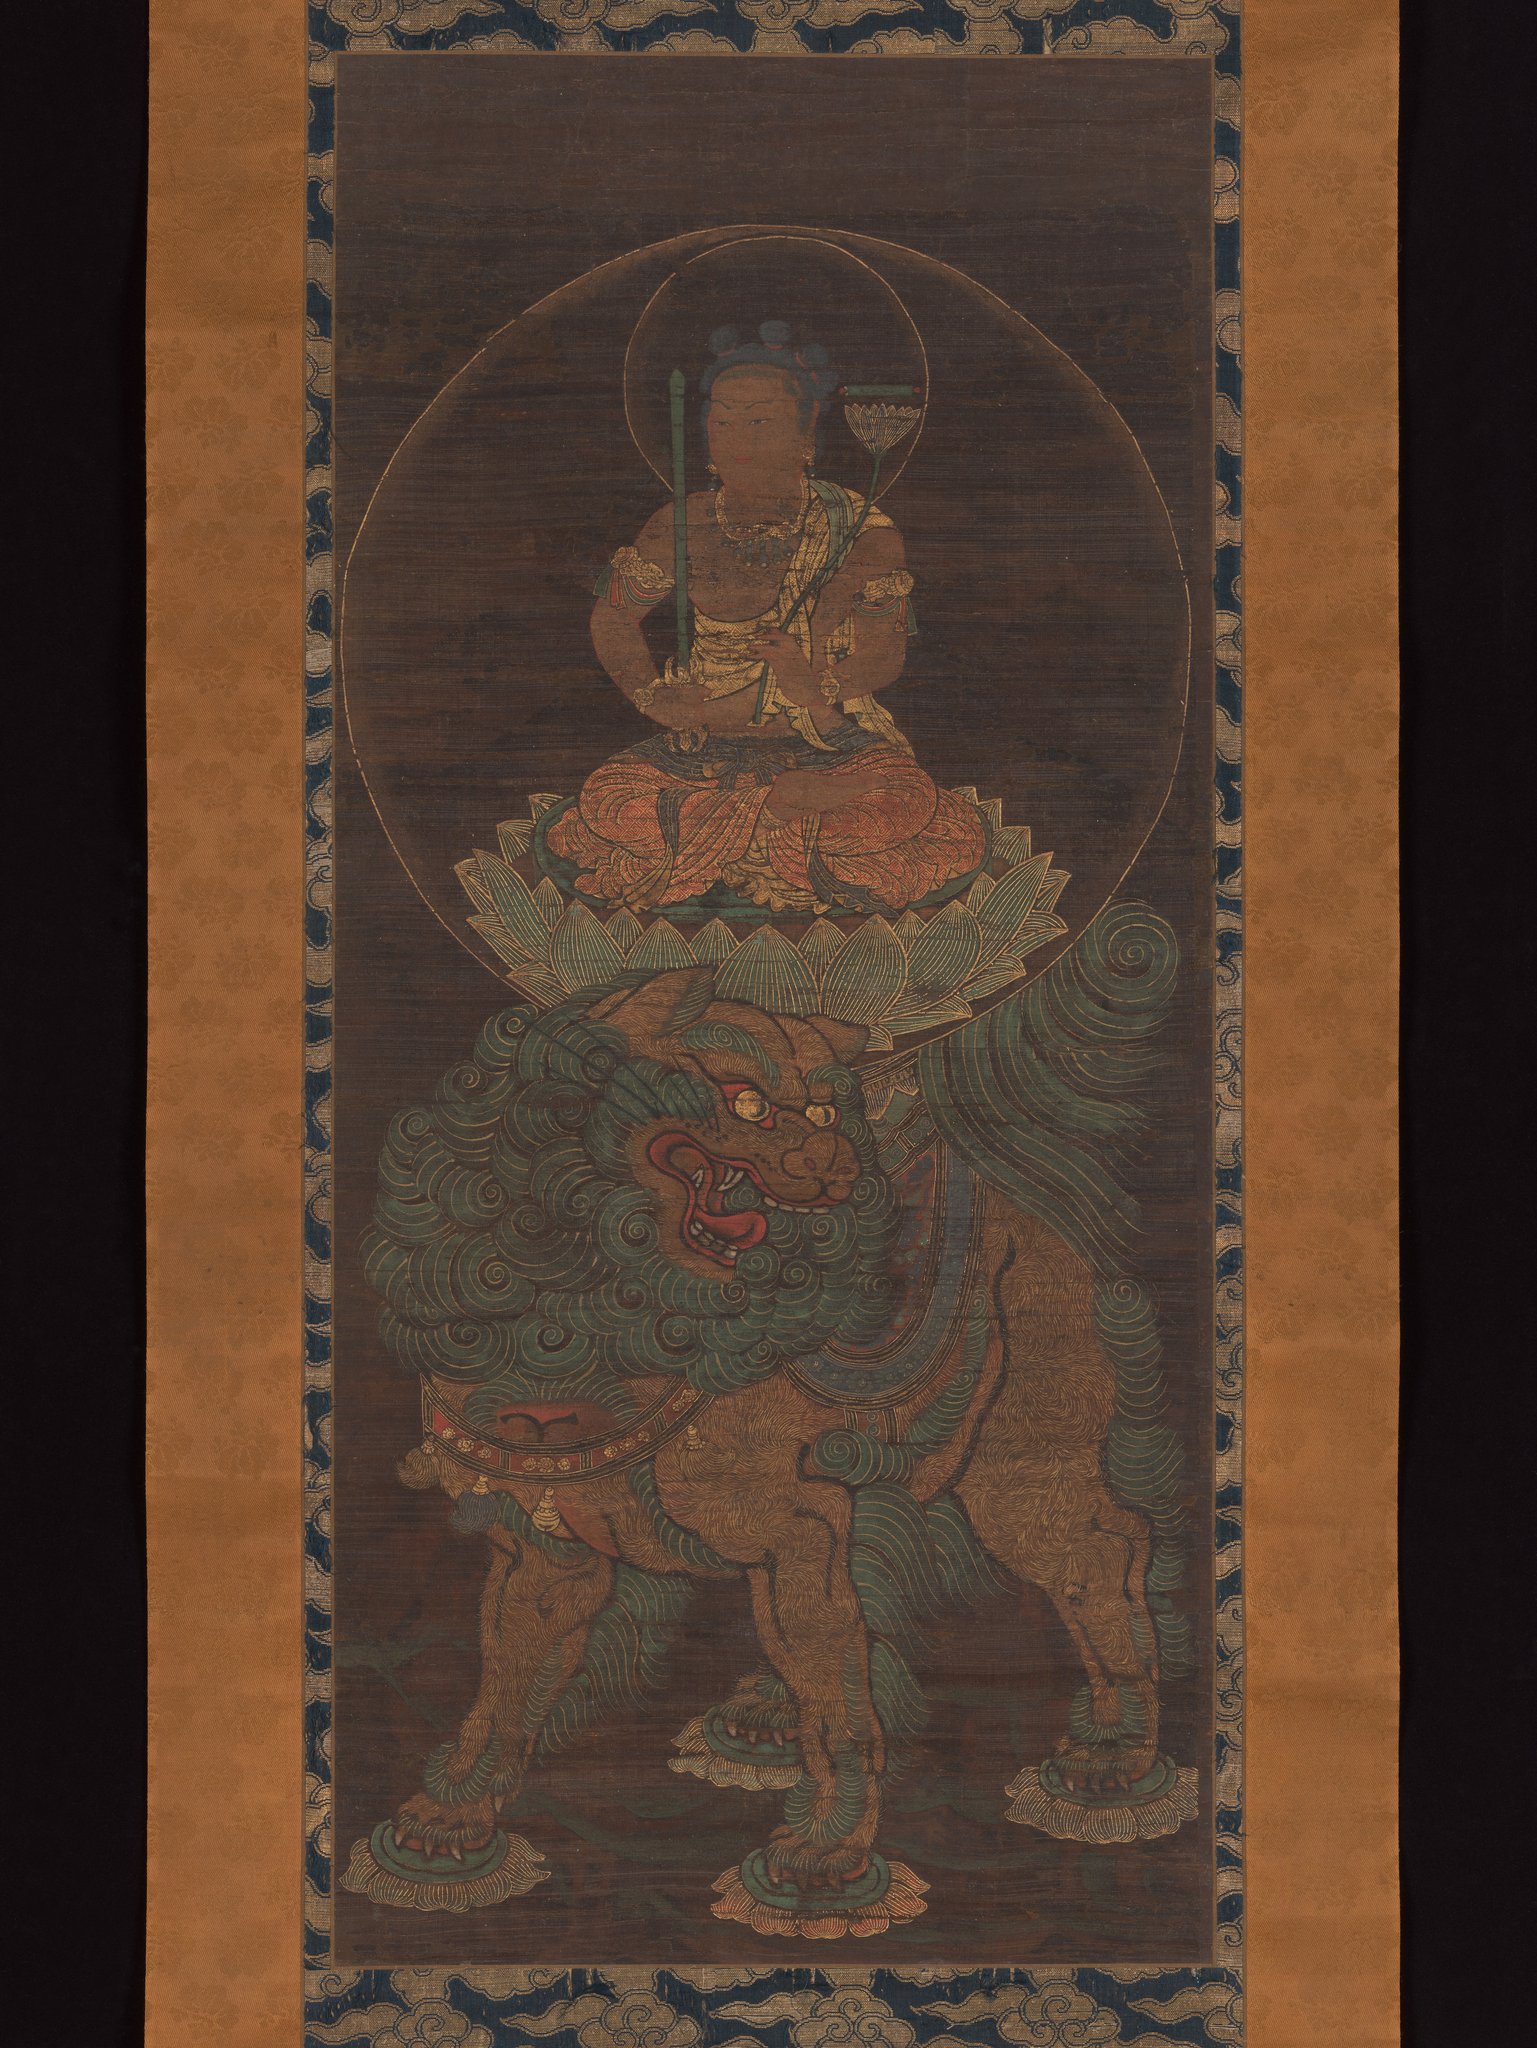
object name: hanging scroll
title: The Bodhisattva Monju (Manjushri) with Five Topknots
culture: japanese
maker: unidentified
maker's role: artist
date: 1301-1400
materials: gold, ink, silk